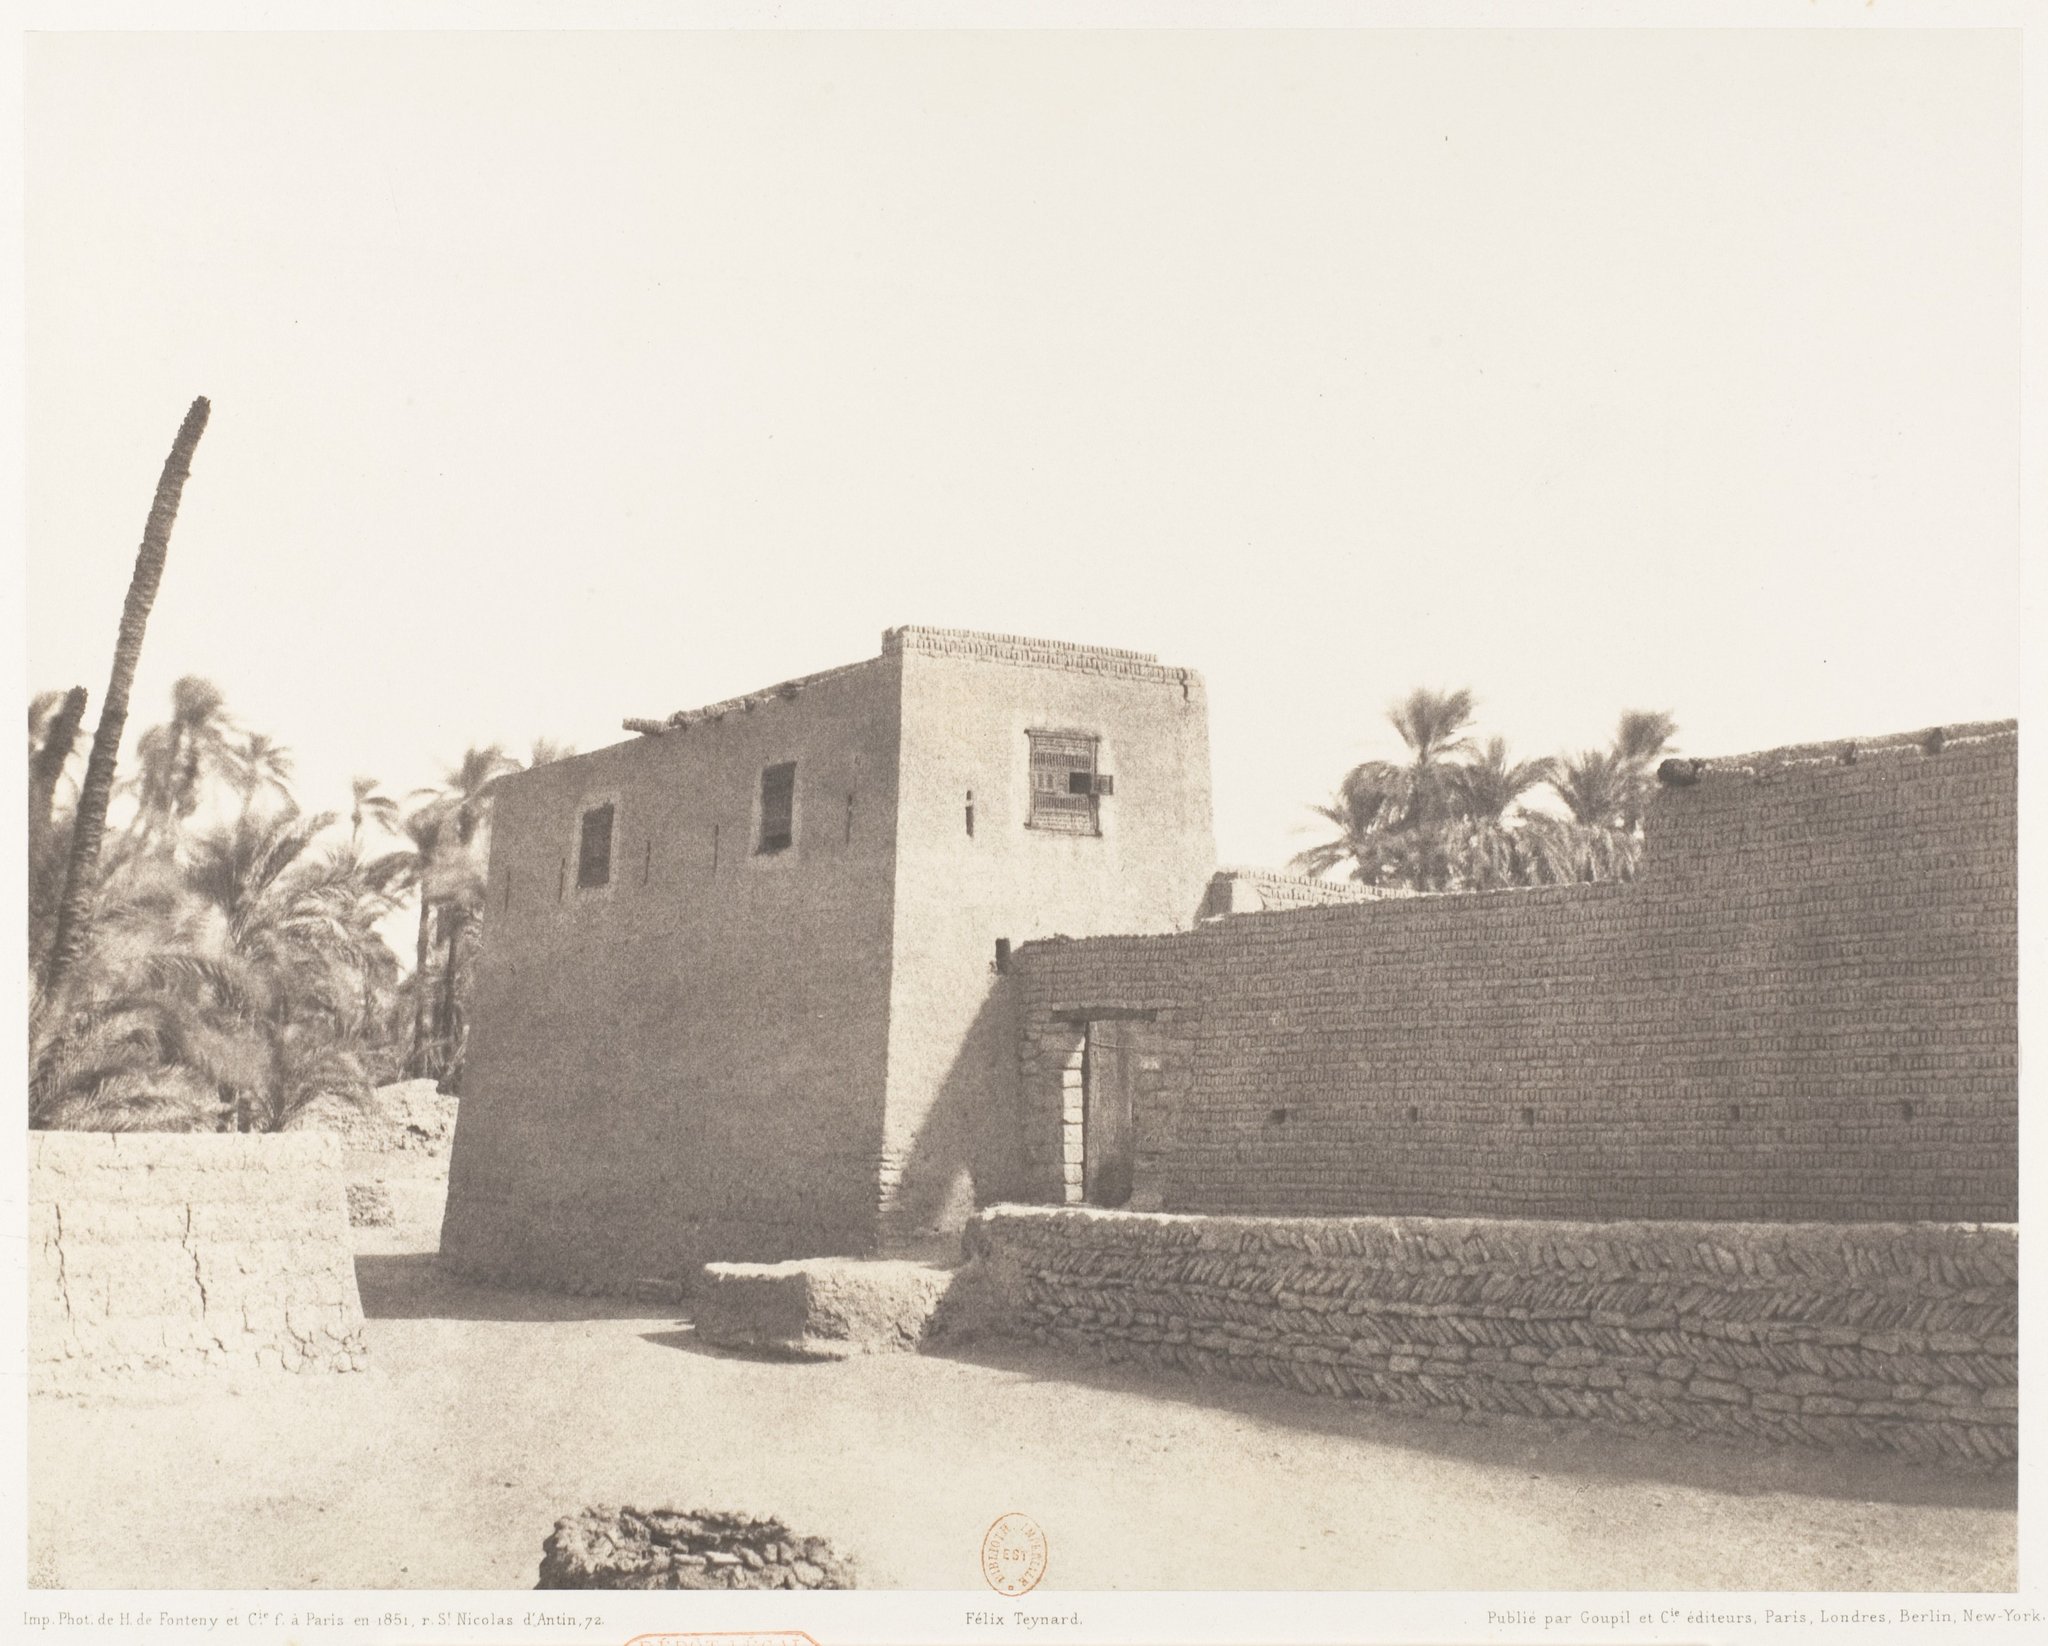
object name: photograph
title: Deîr, Carrefour et Habitation Particulière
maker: félix teynard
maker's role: artist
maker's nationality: french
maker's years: 1817-1892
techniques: paper negative, salted paper print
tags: architecture,houses